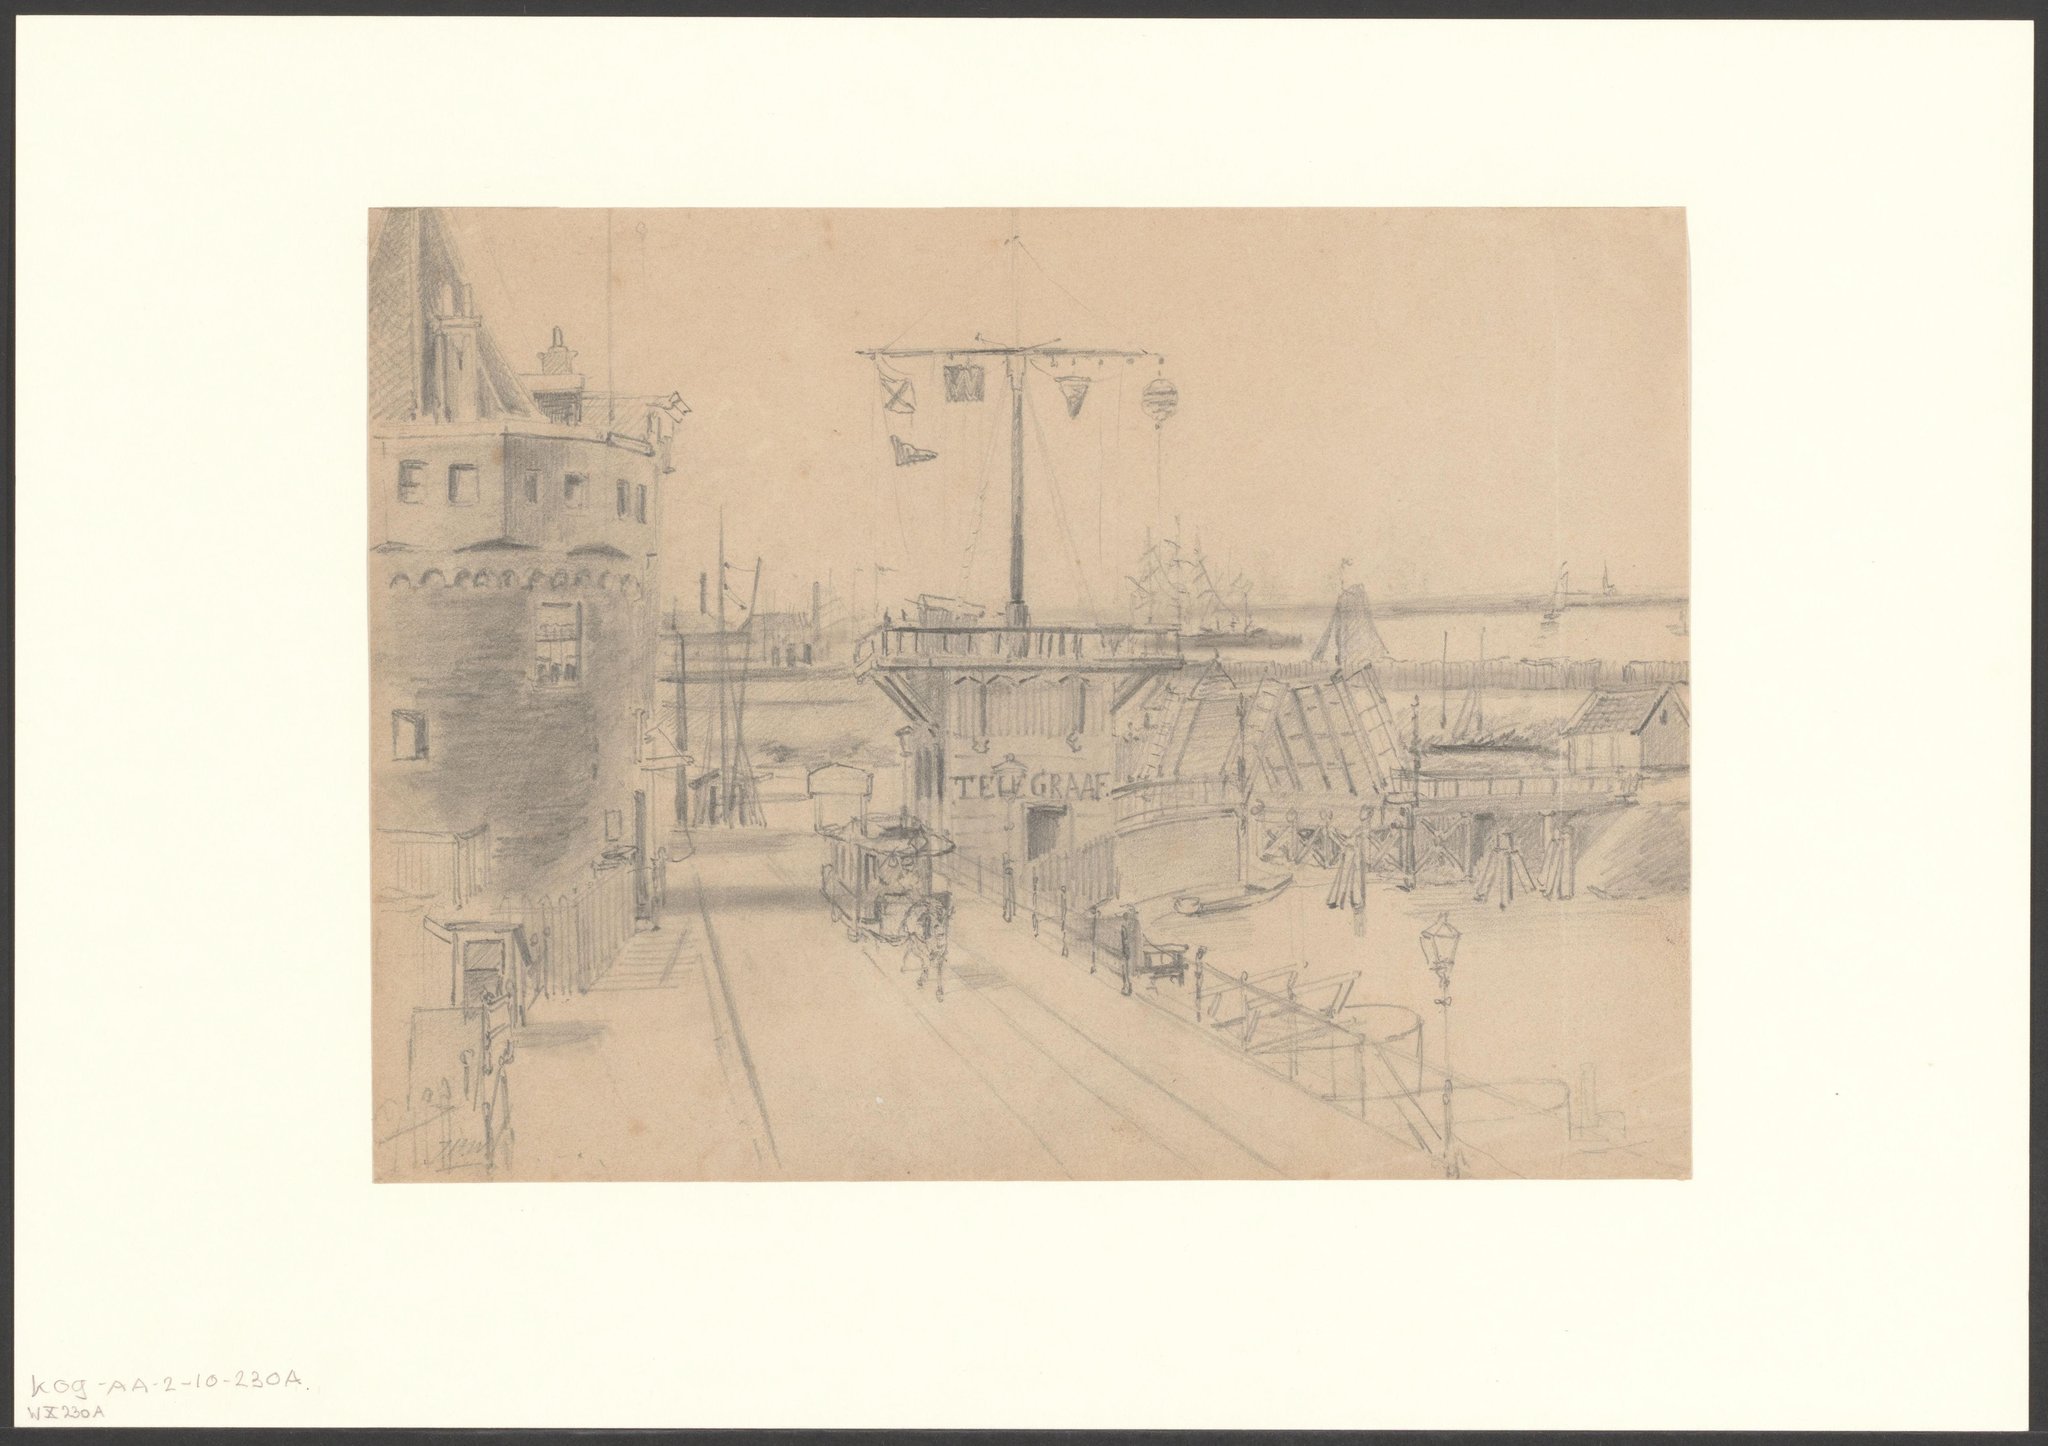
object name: drawing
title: Gezicht op de Schreiershoek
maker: jan hillebrand wijsmuller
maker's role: painter, print maker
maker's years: 1855-1925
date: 1865-1925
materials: paper, pencil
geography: amsterdam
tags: city-view in general; 'veduta', towers ~ fortified city, canal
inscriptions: signature: ‘J.H.W.’, collector's mark: Lugt 800a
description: Tekening binnen de Atlas Van Eck ingedeeld op wijknummer 10.